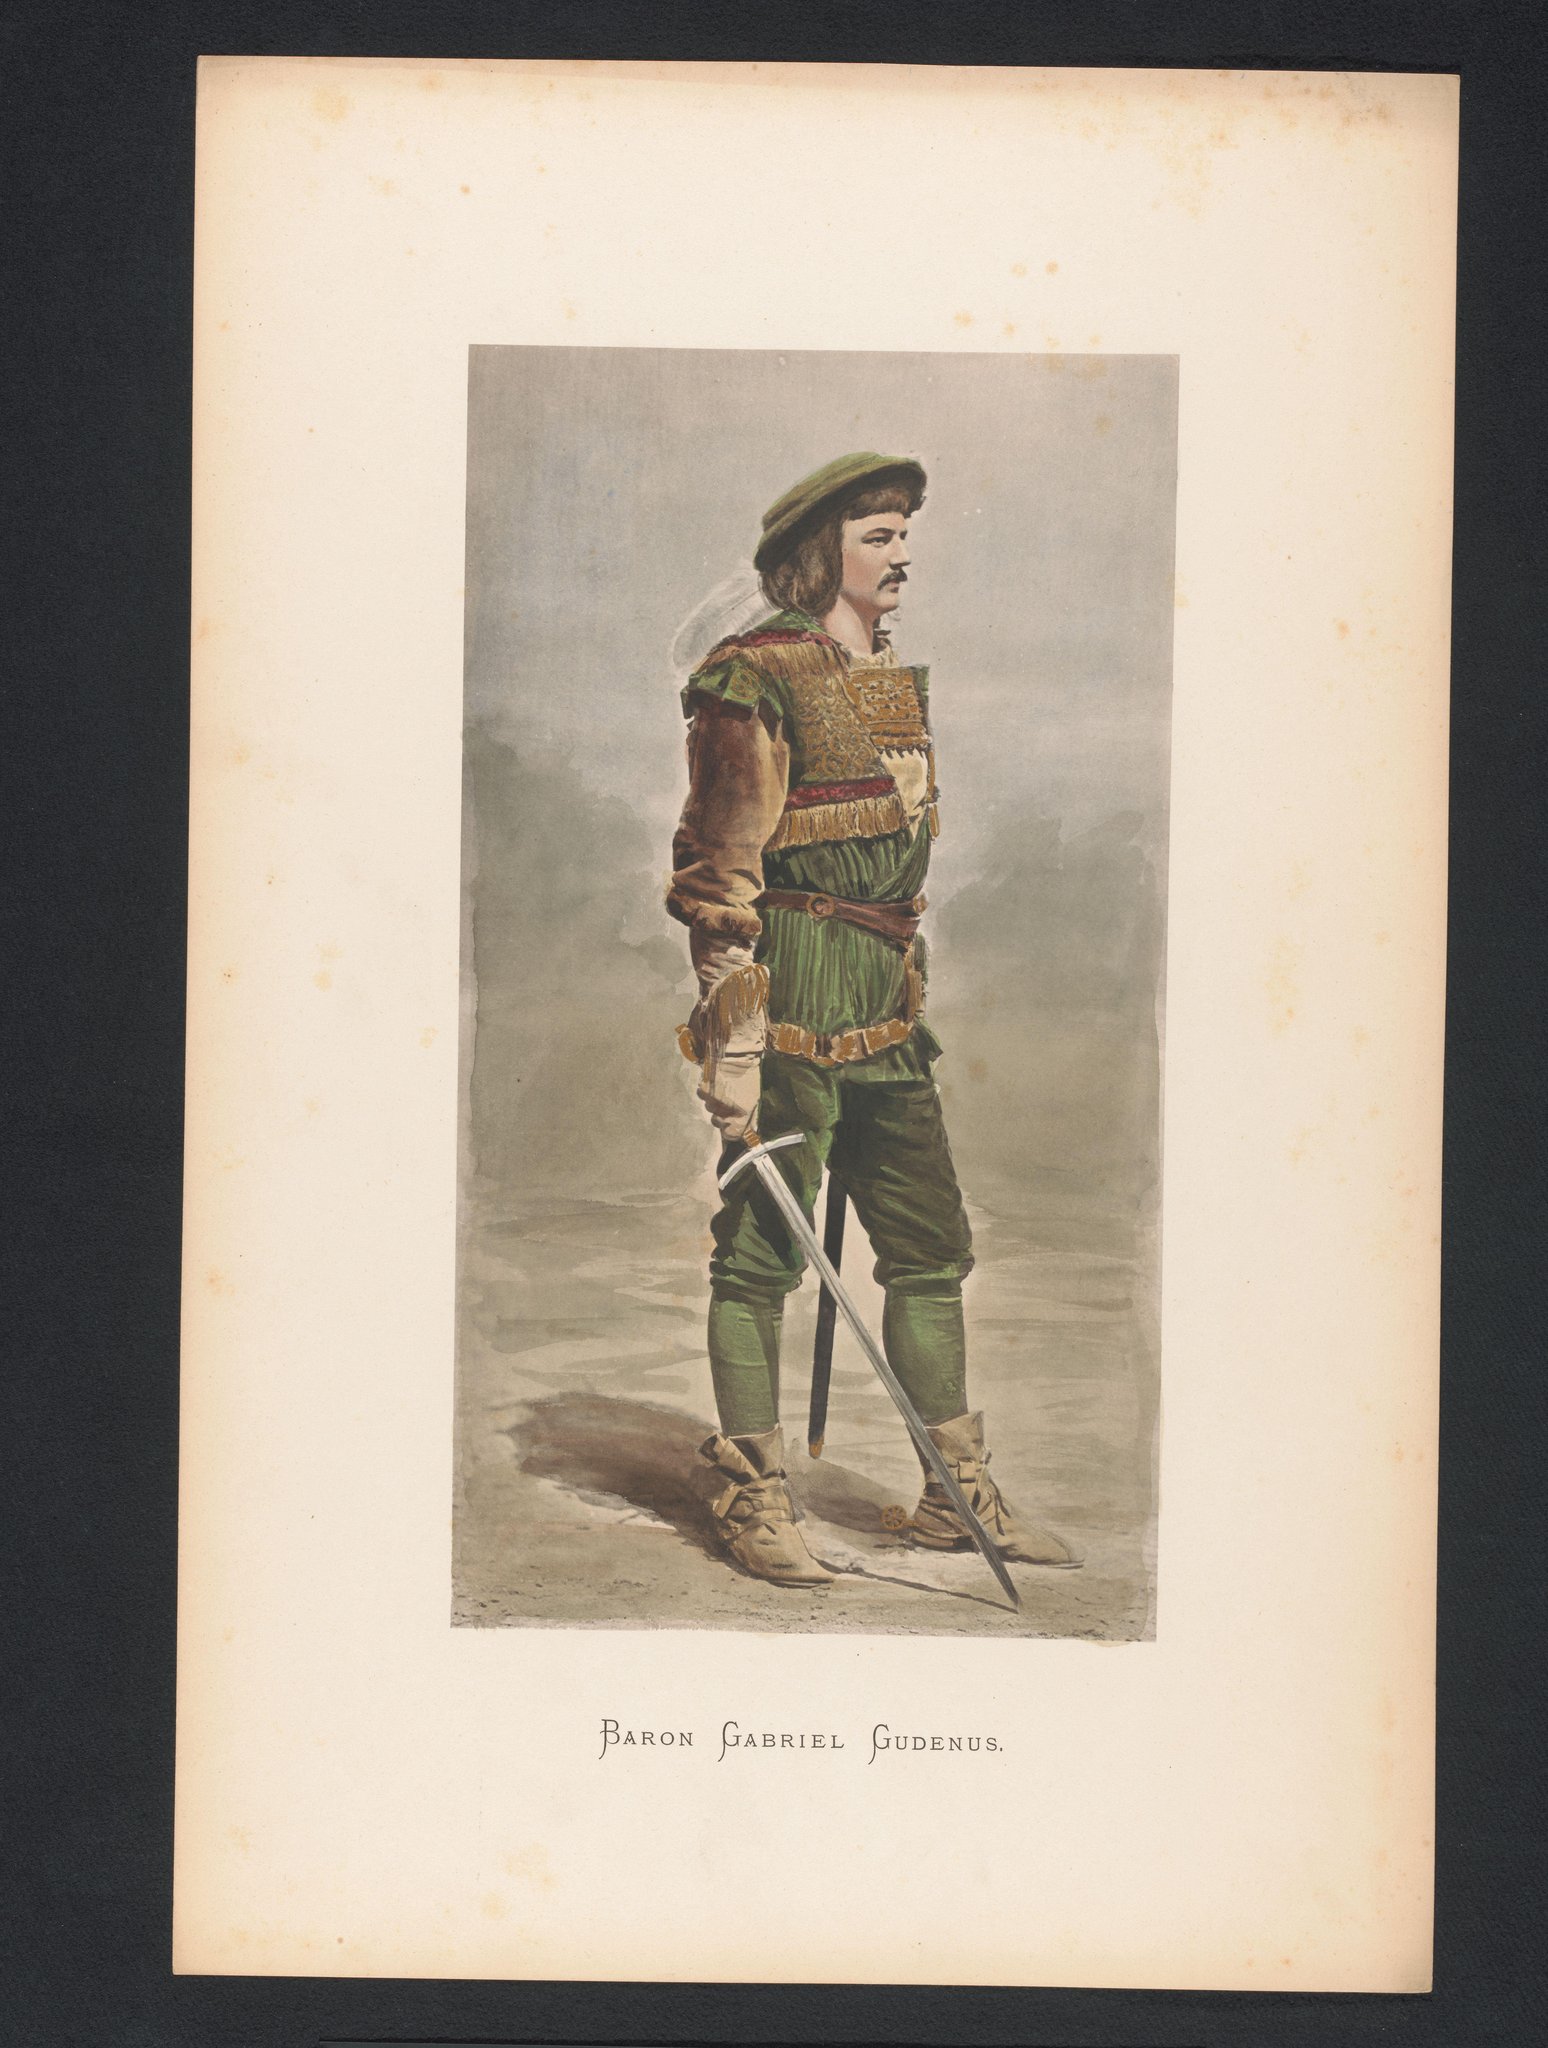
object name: photomechanical print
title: Portret van graaf Gabriel von Gudenus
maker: Anonymous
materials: paper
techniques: photograph, hand coloring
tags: earl, aristocracy; 'aristocratia' (ripa), historical persons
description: Deze prent maakt deel uit van een omslag met 86 prenten op 78 bladen en 11 tekstbladen.